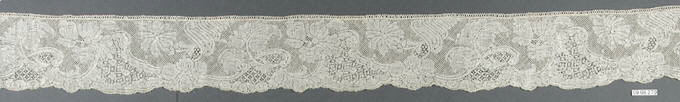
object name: strip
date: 1701-1800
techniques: lace